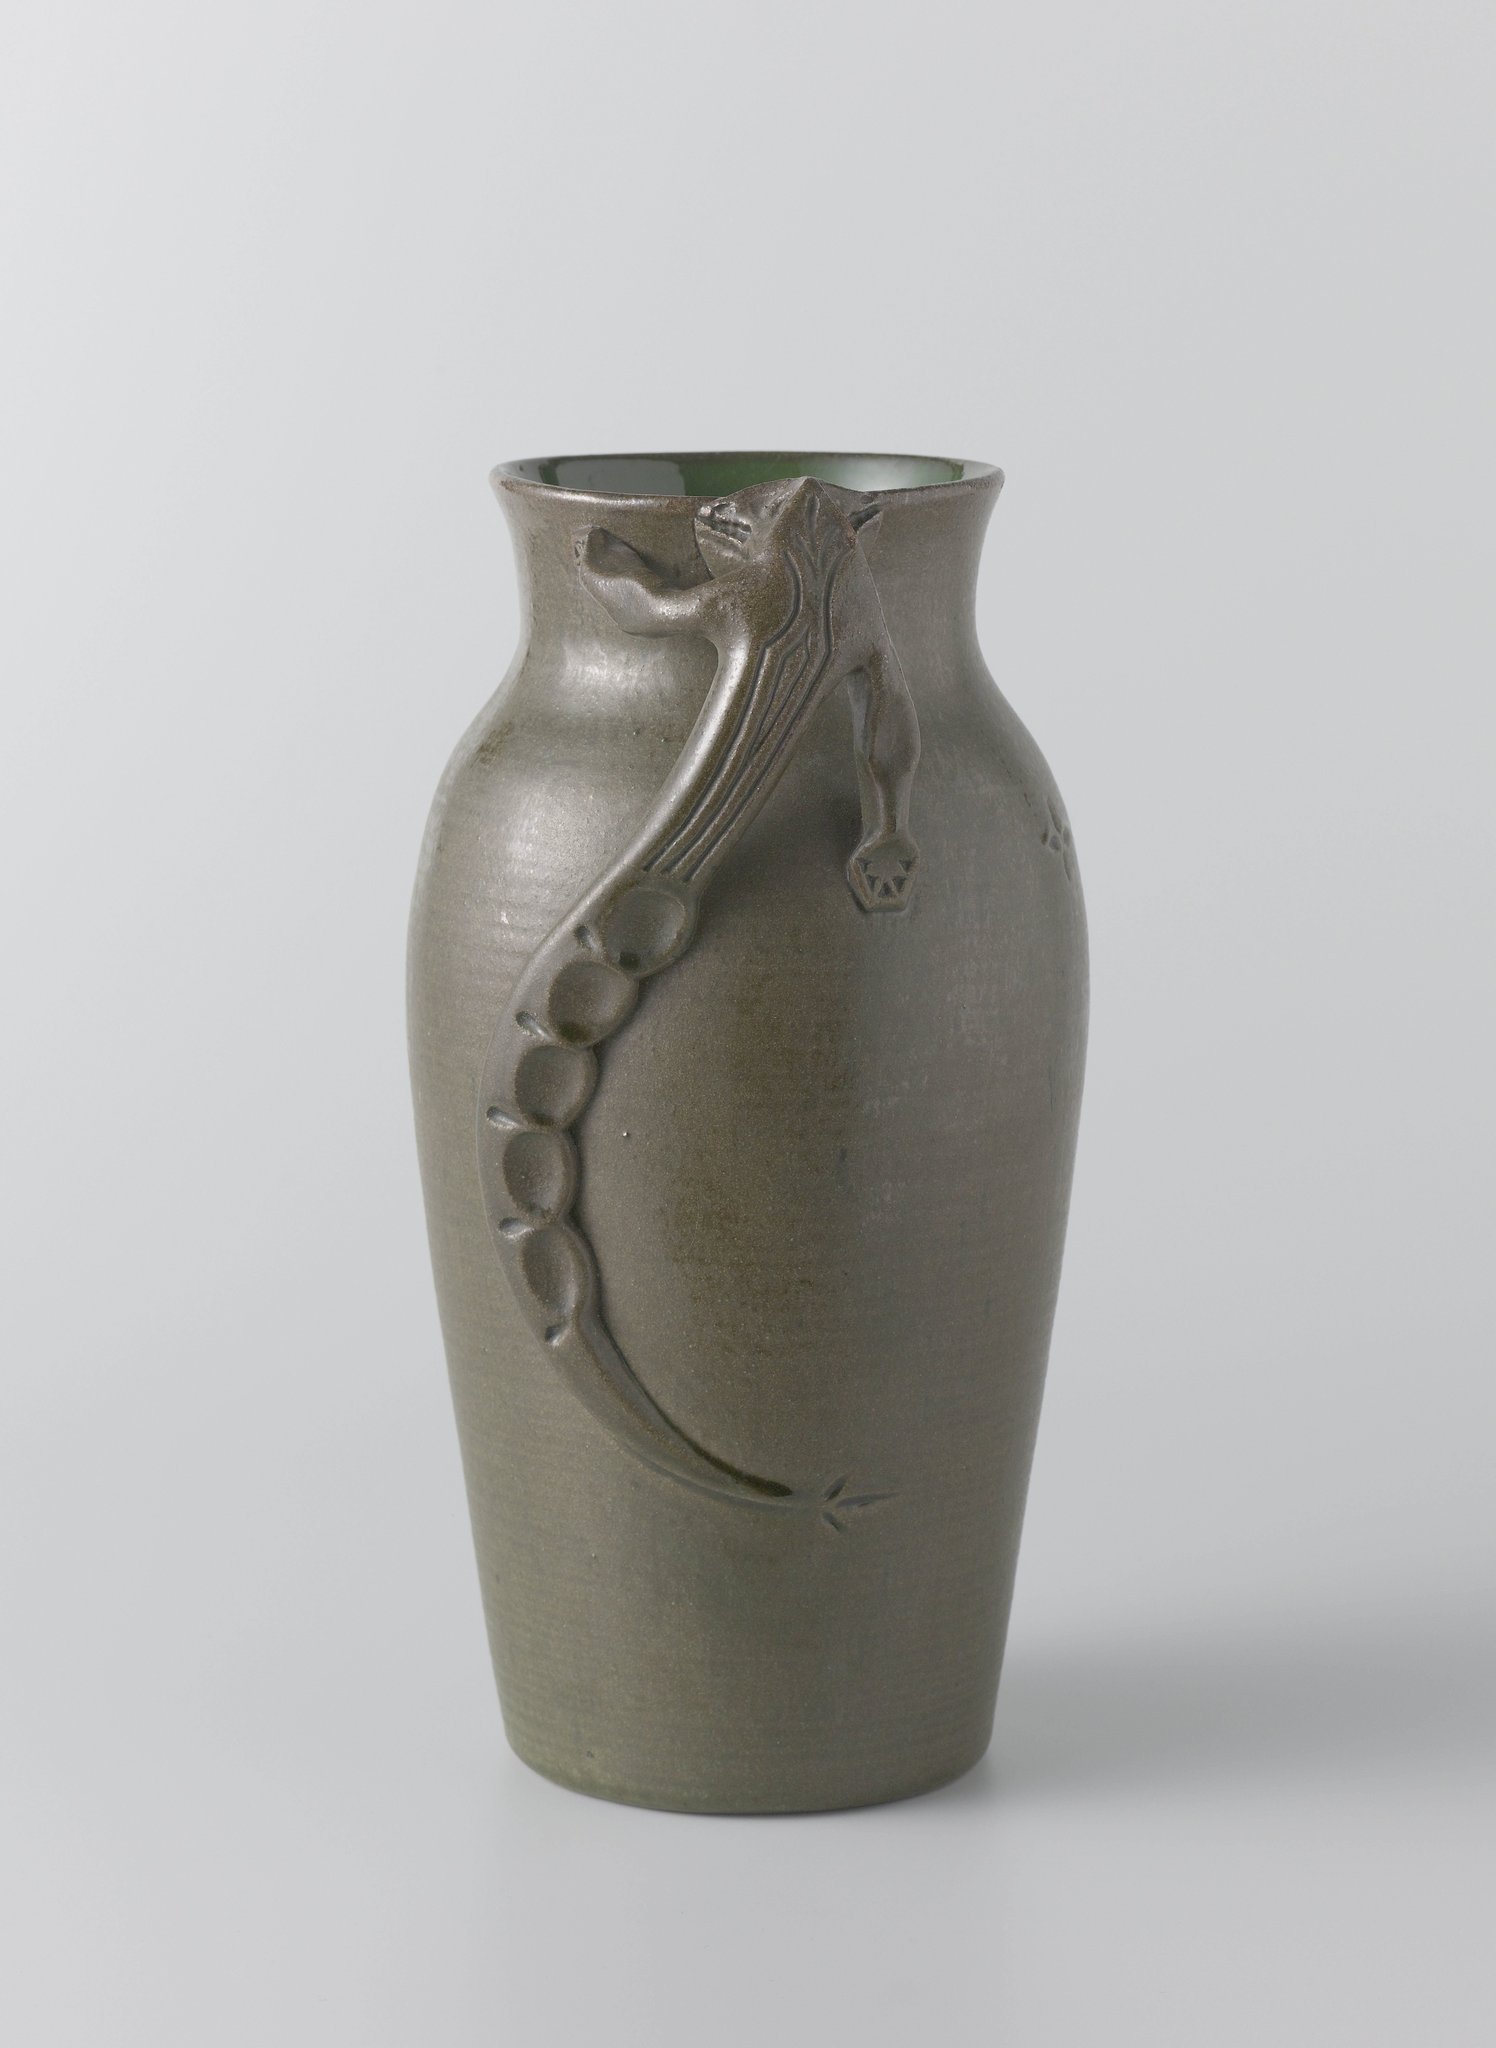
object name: vase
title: Vaas met oor in de vorm van een salamander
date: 1916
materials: earthenware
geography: leiderdorp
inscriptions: mark: ‘stempel van W.C. Brouwer en NF (Ned. Fabrikaat), ingegrift 1 11 6 en 133’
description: Vaas met oor in de vorm van een salamander, van aardewerk, versierd met groene glazuur. De binnenkant is donkergroen geglazuurd. Op de wand zijn vierblad-motieven ingestempeld.